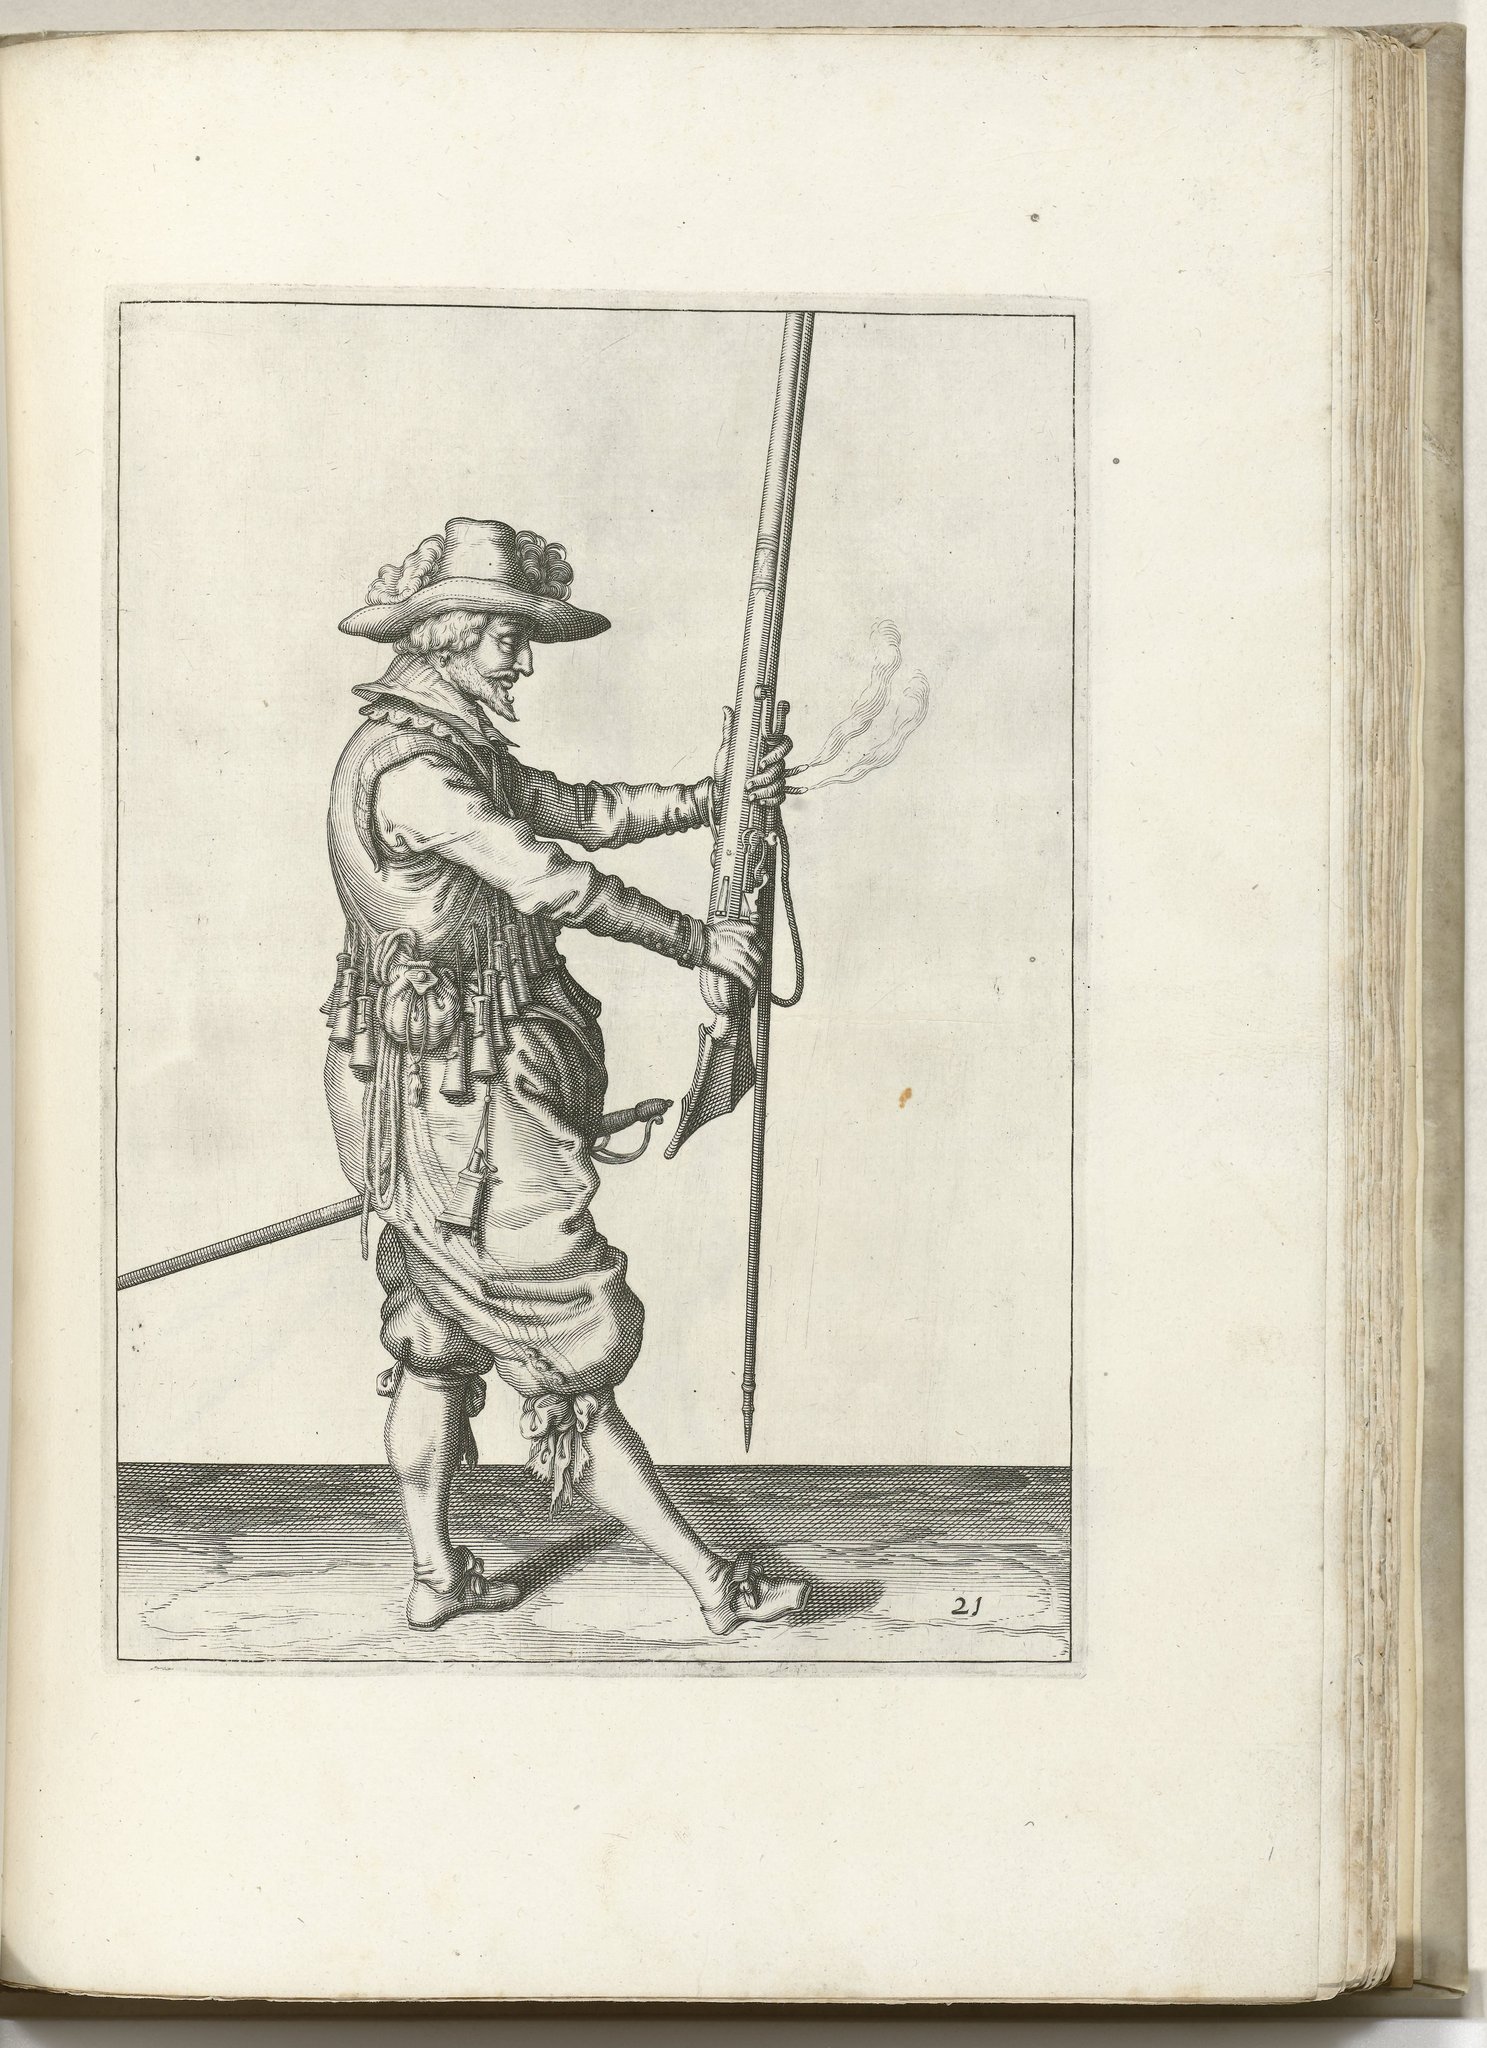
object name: print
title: Soldaat die zijn musket met beide handen rechtop voor zich vasthoudt (nr. 21), ca. 1600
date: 1597-1607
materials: paper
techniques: engraving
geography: northern netherlands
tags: the hague, maurice (prince of orange), handling of weapons ~ military training, weapons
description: Een soldaat, ten voeten uit, naar rechts, die een musket (een bepaald type vuurwapen) met beide handen voor zich vasthoudt, de loop omhoog wijzend, om het naar zijn linkerzijde te brengen (nr. 21), ca. 1600. In zijn linkerhand behalve de loop van het musket ook een furket (musketvork) en een brandende lont. Plaat 21 in de instructies voor het hanteren van het musket: Corte onderrechtinghe op de figuerliicke afbeeldinghe, soo veel aengaet het recht ghebruyck vant Musquet. Onderdeel van de illustraties in: J. de Gheyn, Wapenhandelinghe van Roers Musquetten ende spiessen, 's-Gravenhage, 1607. Krijgswezen rond 1600.